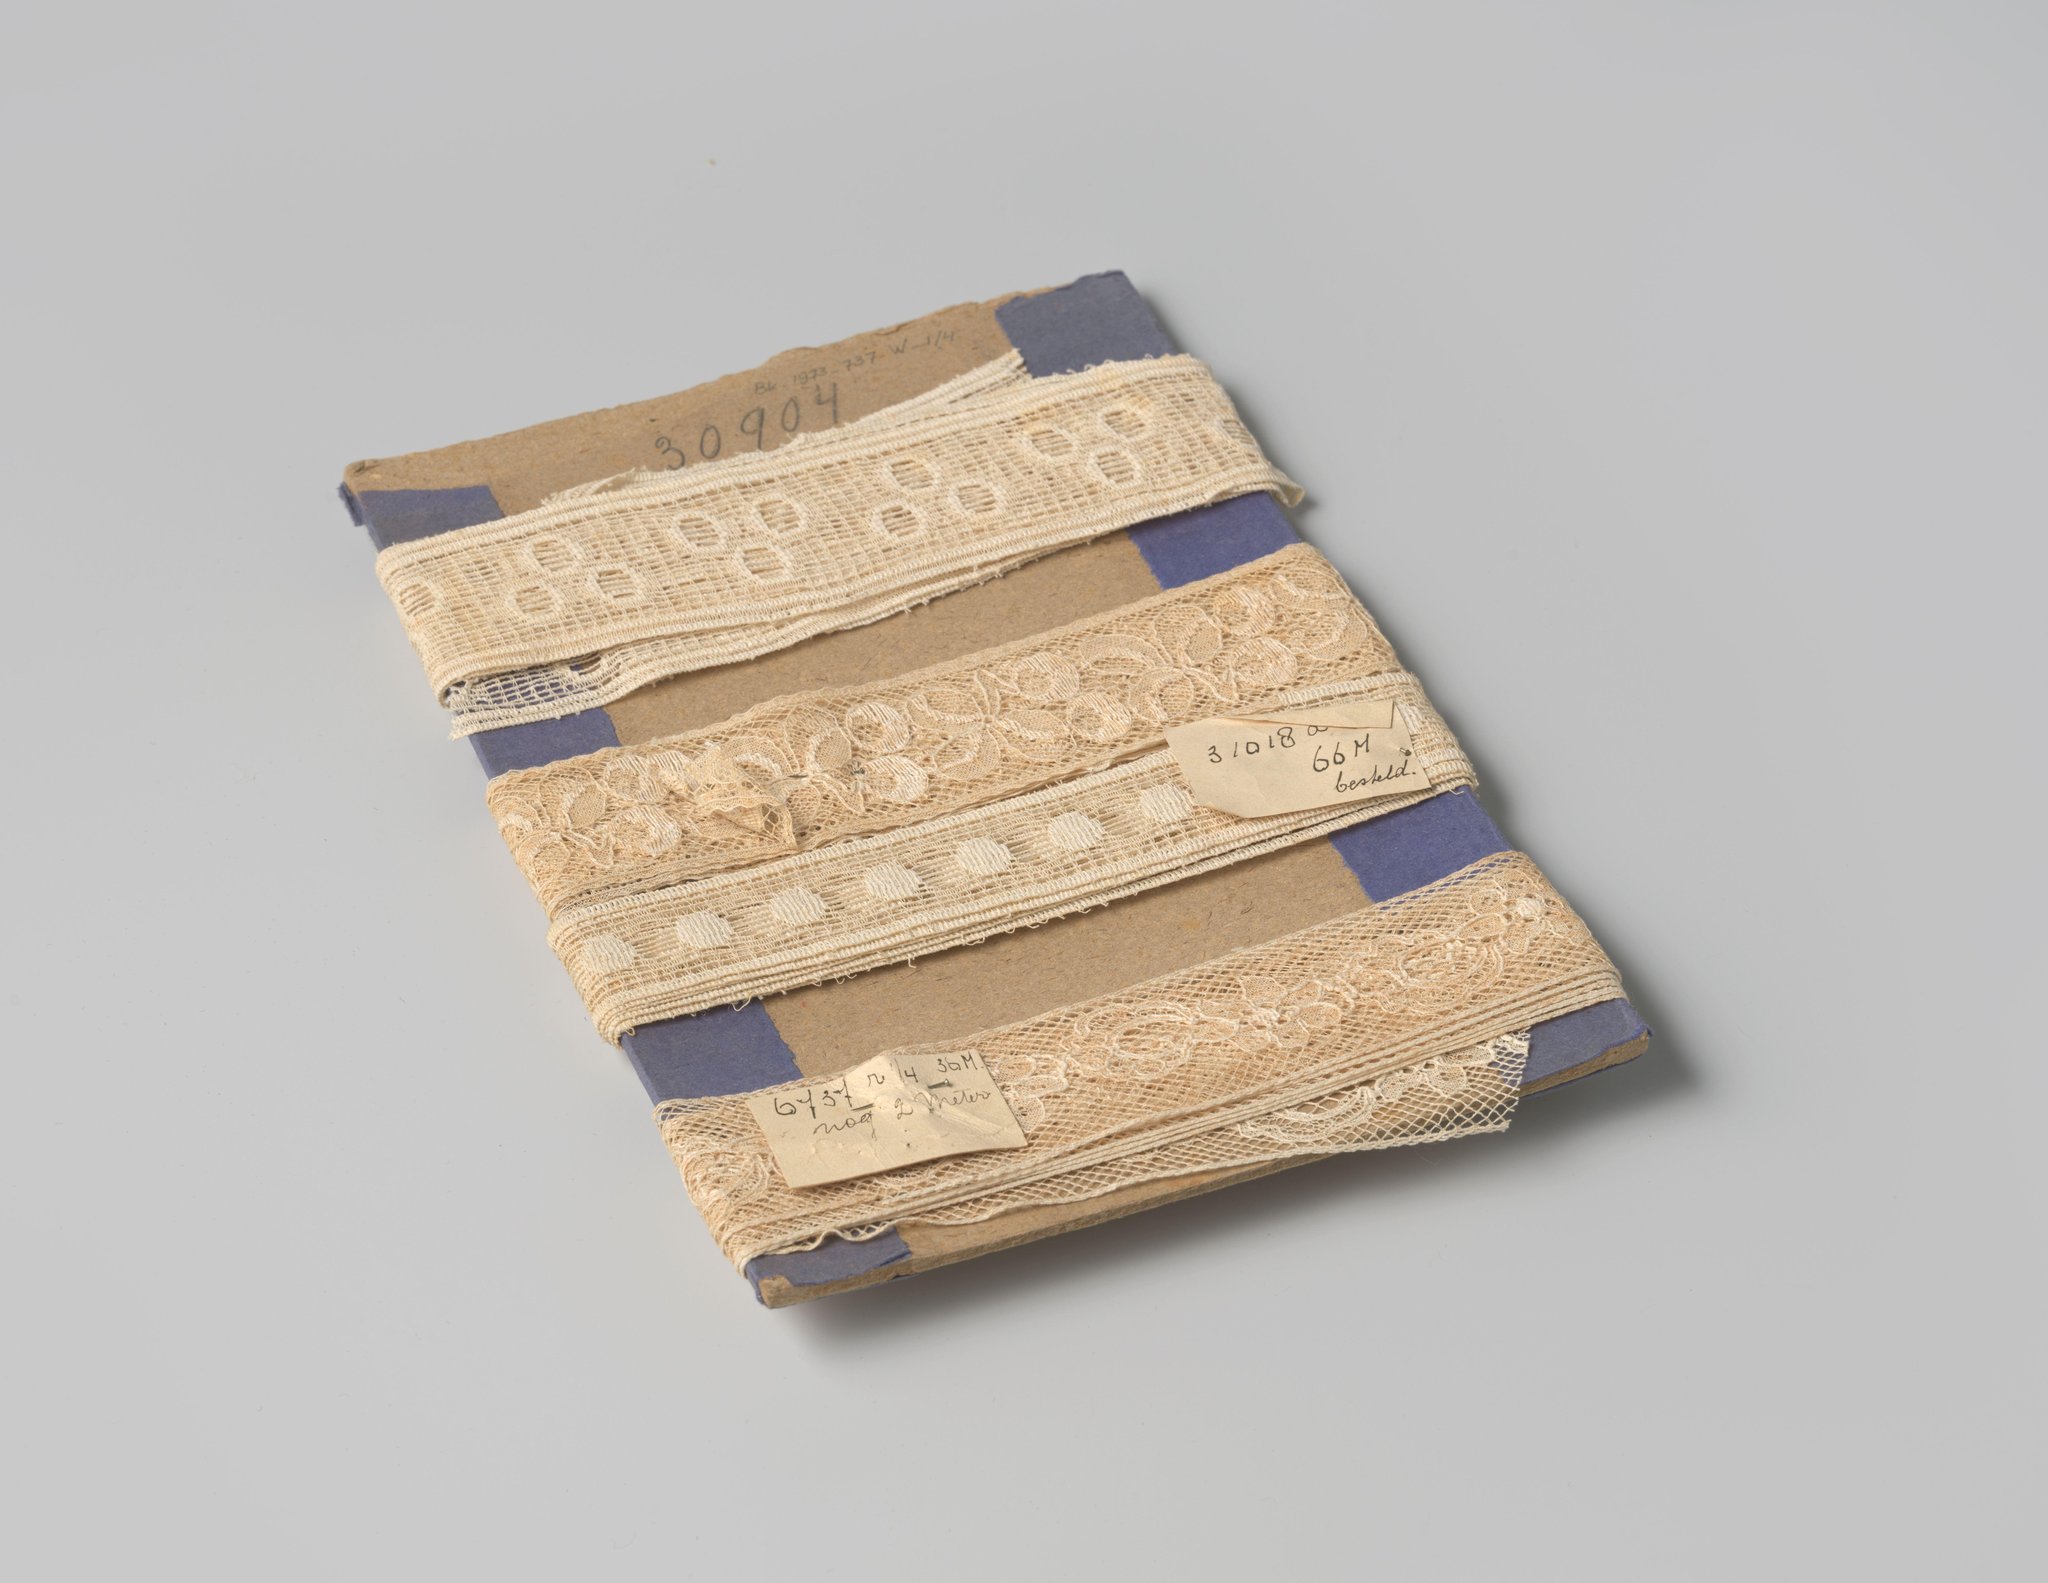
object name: entre deux, tussenzetsel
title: Tussenzetsel van roomwitte machinale kant met patroon van telkens drie bijeengeplaatste cirkels, op karton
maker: gustav schnitzler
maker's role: paraplufabrikant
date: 1925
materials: cardboard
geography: nijmegen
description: Tussenzetsel van roomwitte machinale kant met patroon van telkens drie bijeengeplaatste cirkels, op karton.